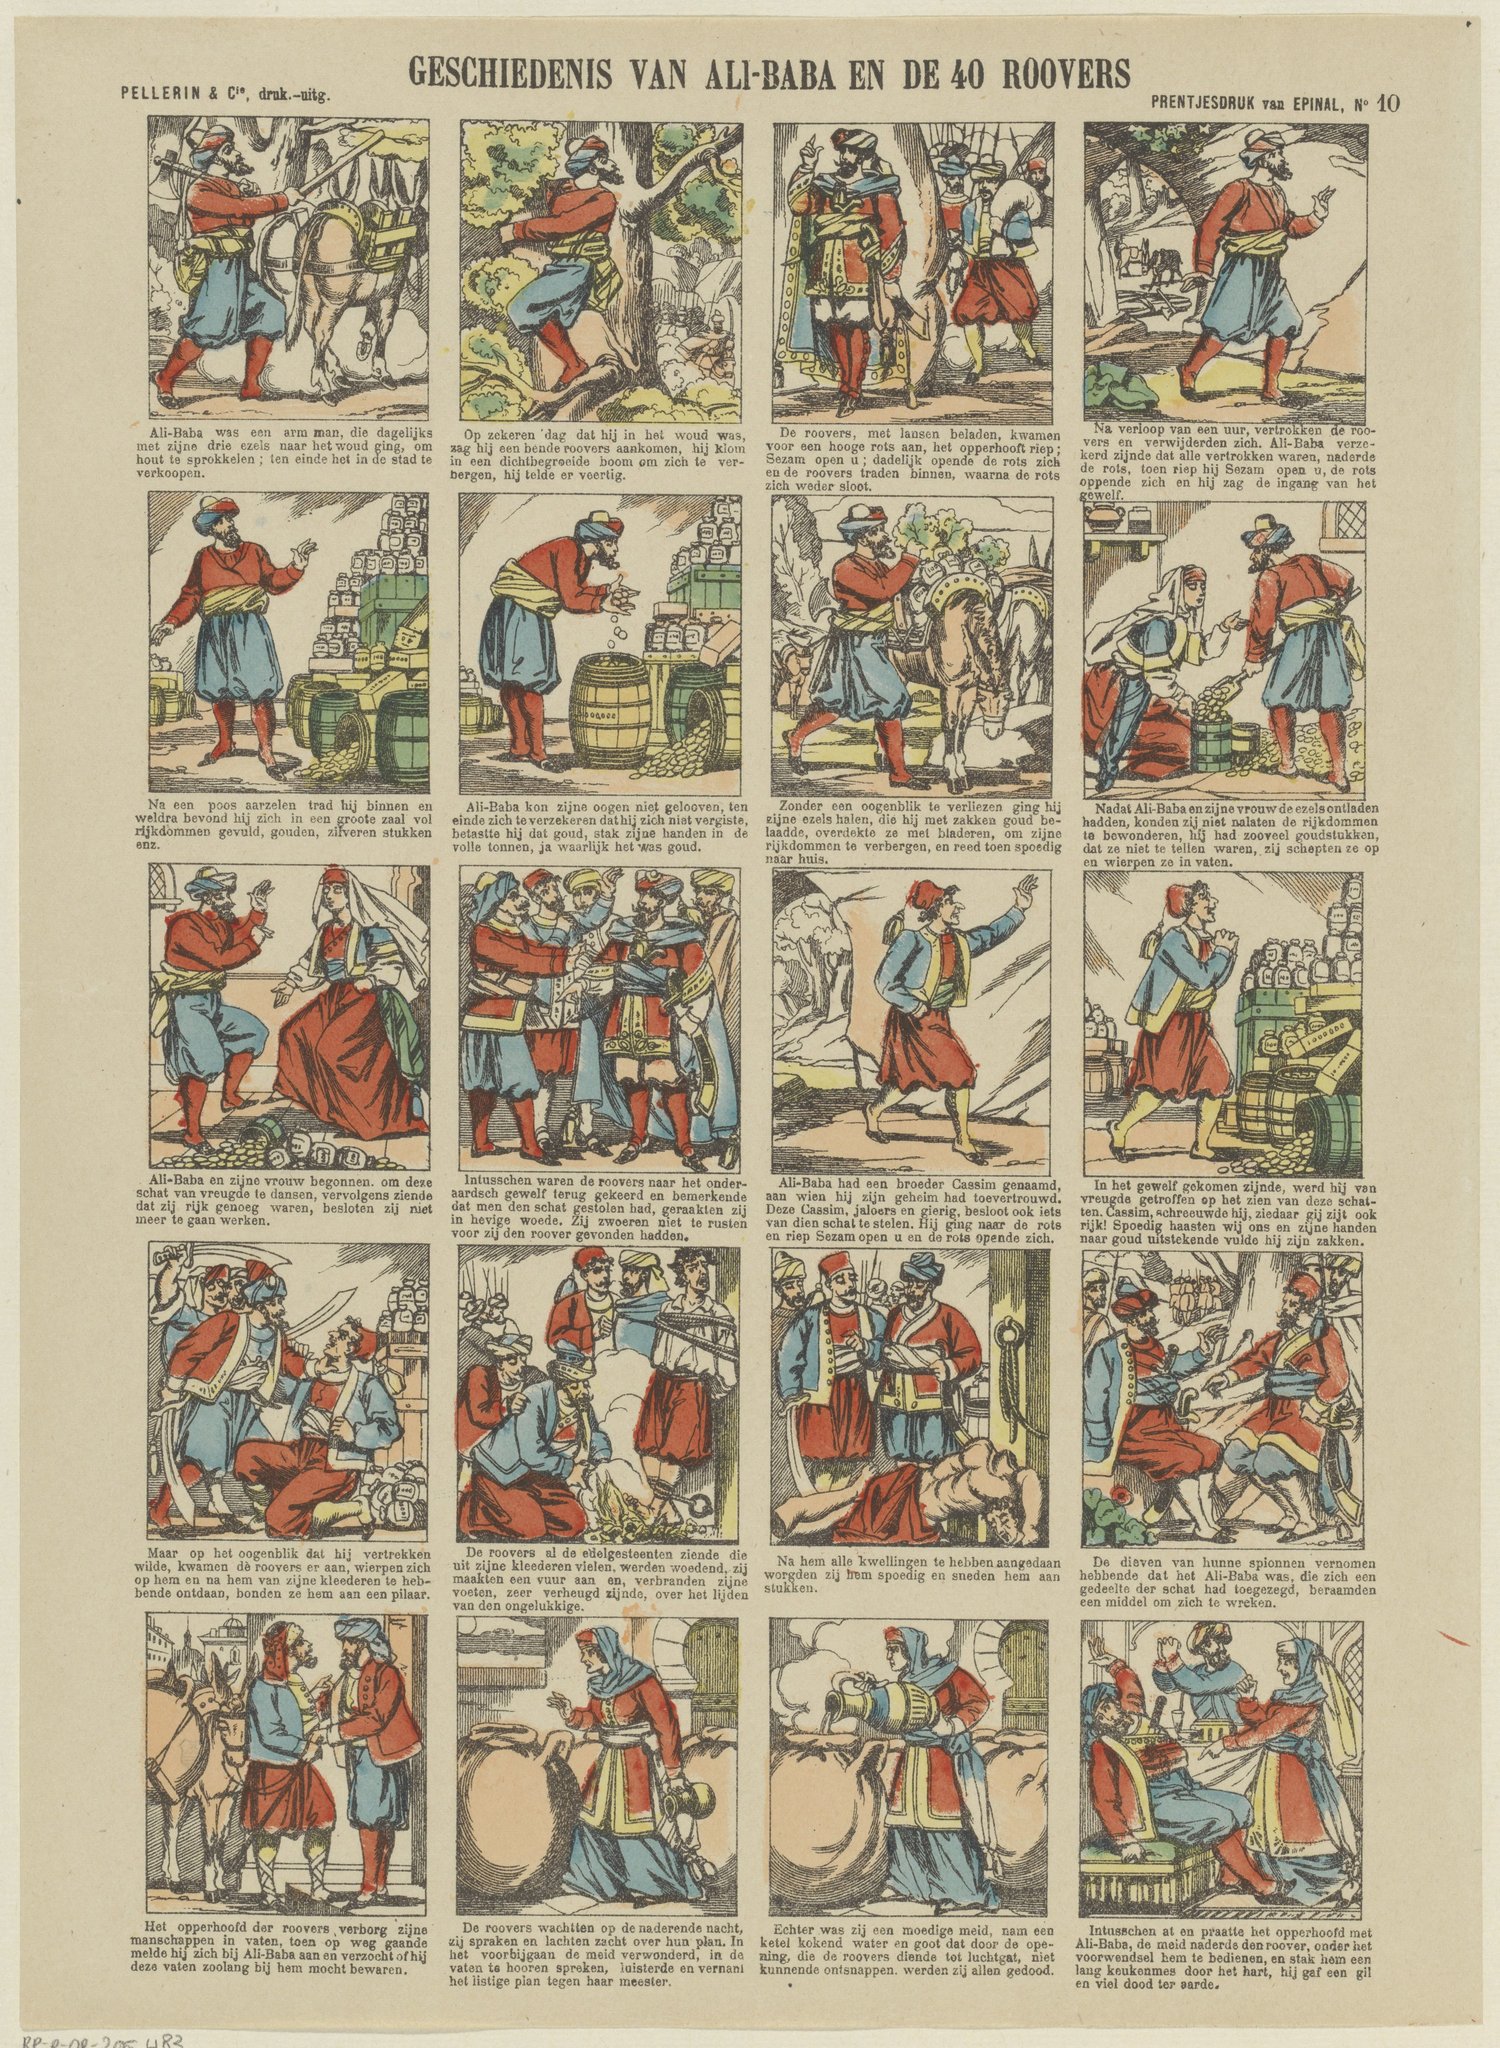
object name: popular print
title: Prentjesdruk van Épinal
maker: Anonymous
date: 1902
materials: paper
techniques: colour, letterpress printing, lithograph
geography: epinal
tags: tales and fairy tales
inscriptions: collector's mark: Lugt 2760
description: Blad met 20 voorstellingen uit het sprookje van Ali Baba en de veertig rovers (verhaal uit Duizend-en-één nacht). Onder elke afbeelding een onderschrift. Genummerd rechtsboven: No 10.